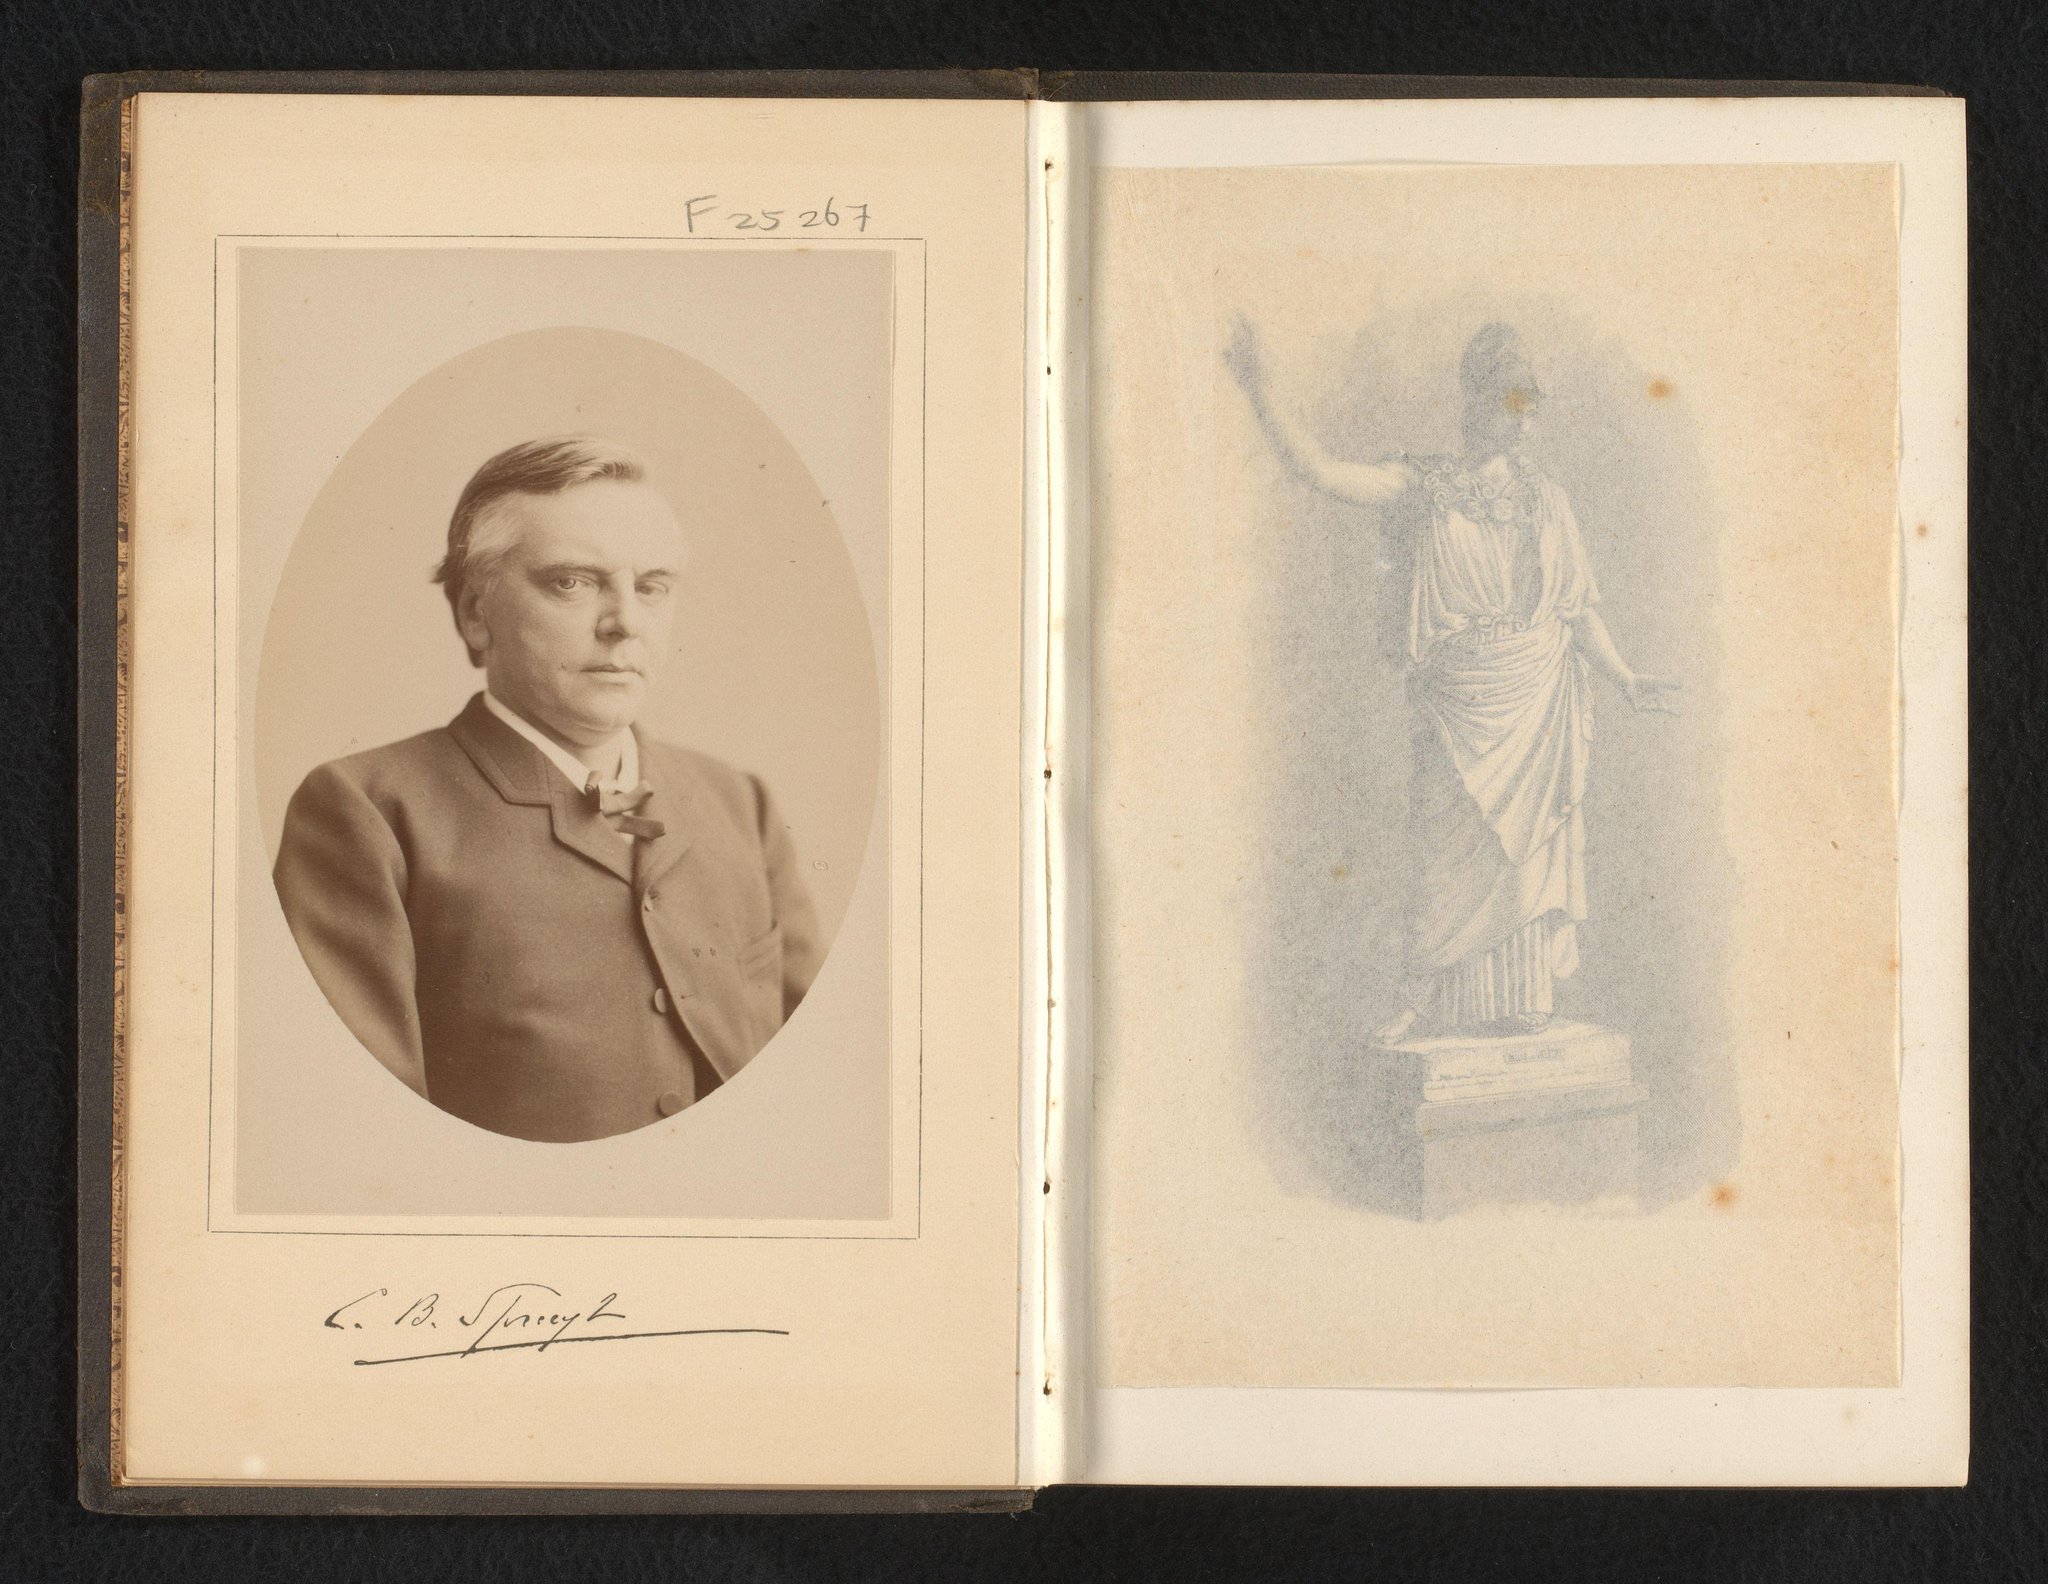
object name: page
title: Portret van Cornelis Bellaar Spruyt, hoogleraar letteren en wijsbegeerte aan de Universiteit van Amsterdam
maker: Anonymous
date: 1888-1889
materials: paper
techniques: albumen print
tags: historical persons, professor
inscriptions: signature: ‘C.B. Spruyt’